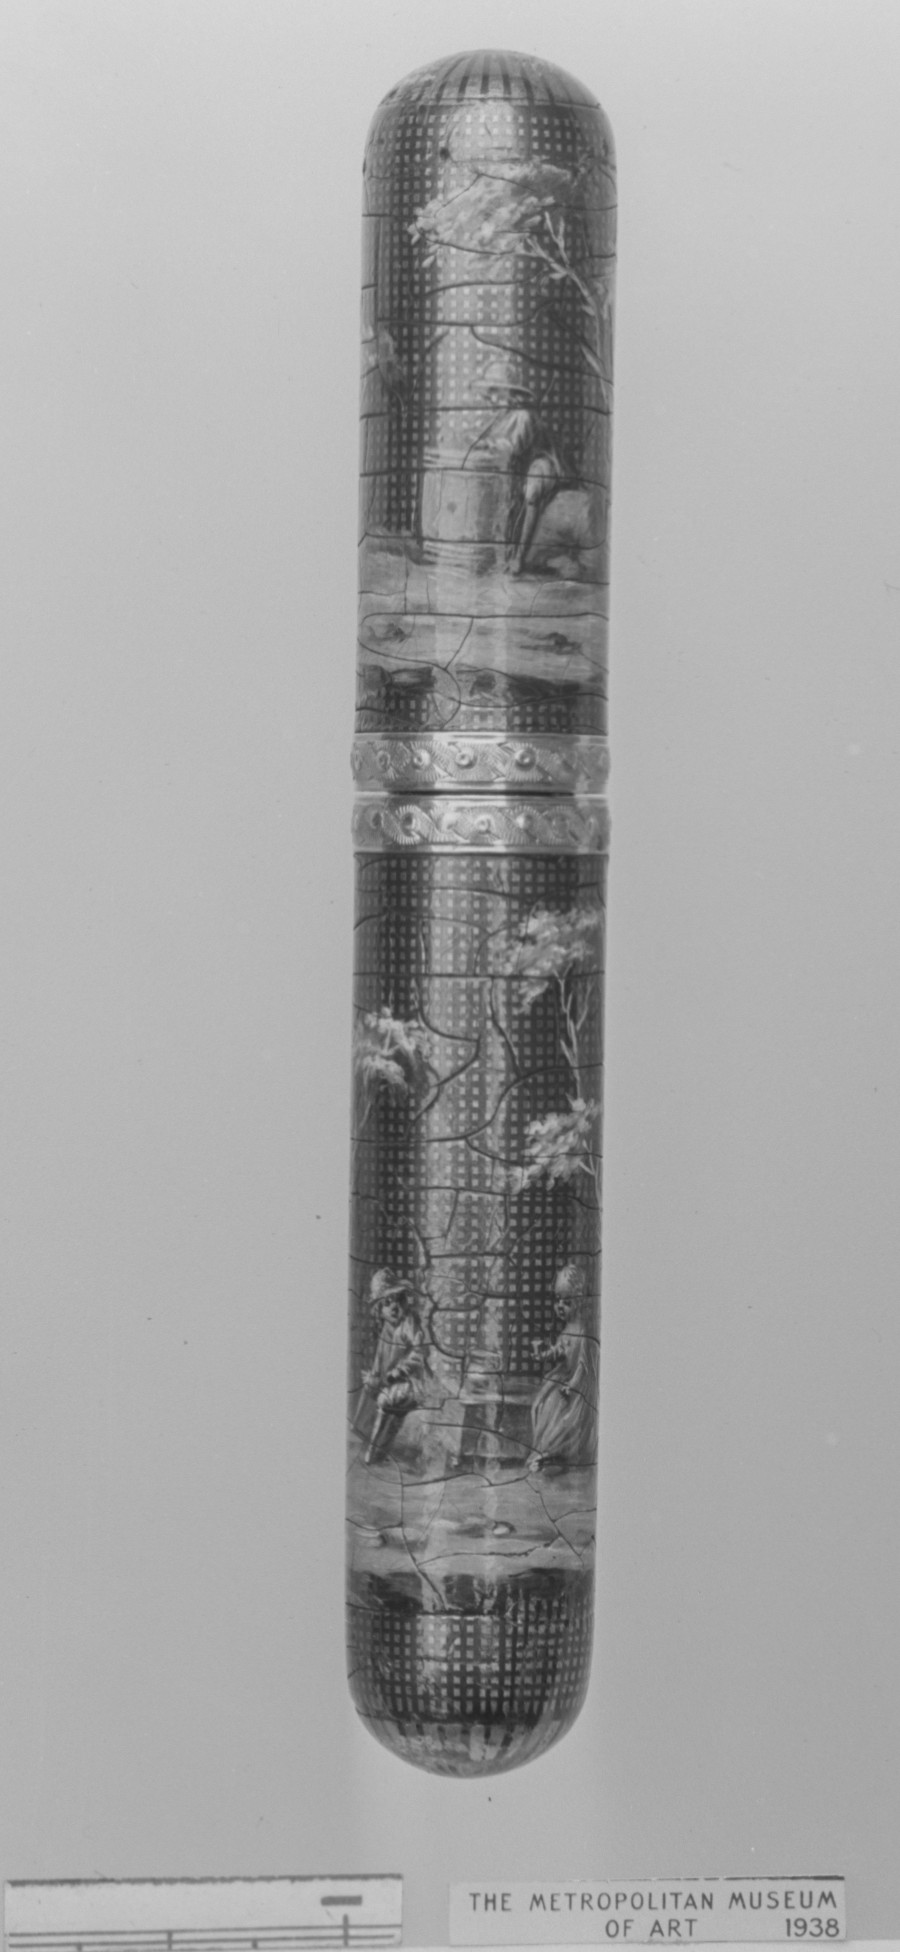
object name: étui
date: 1751-1775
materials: gold, shell, wood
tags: boys,girls,trees